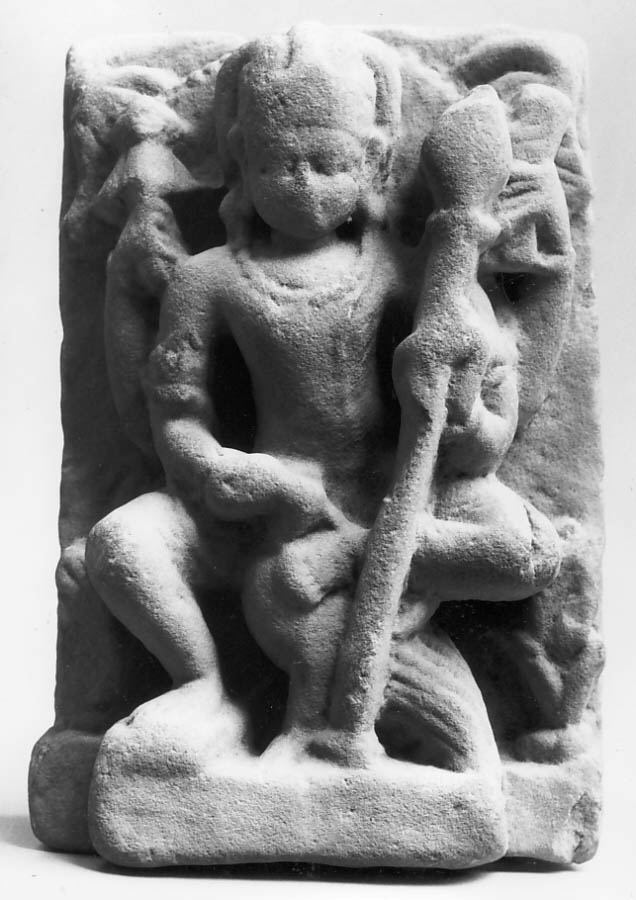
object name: figure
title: Karttikeya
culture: indian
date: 801-1000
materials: stone